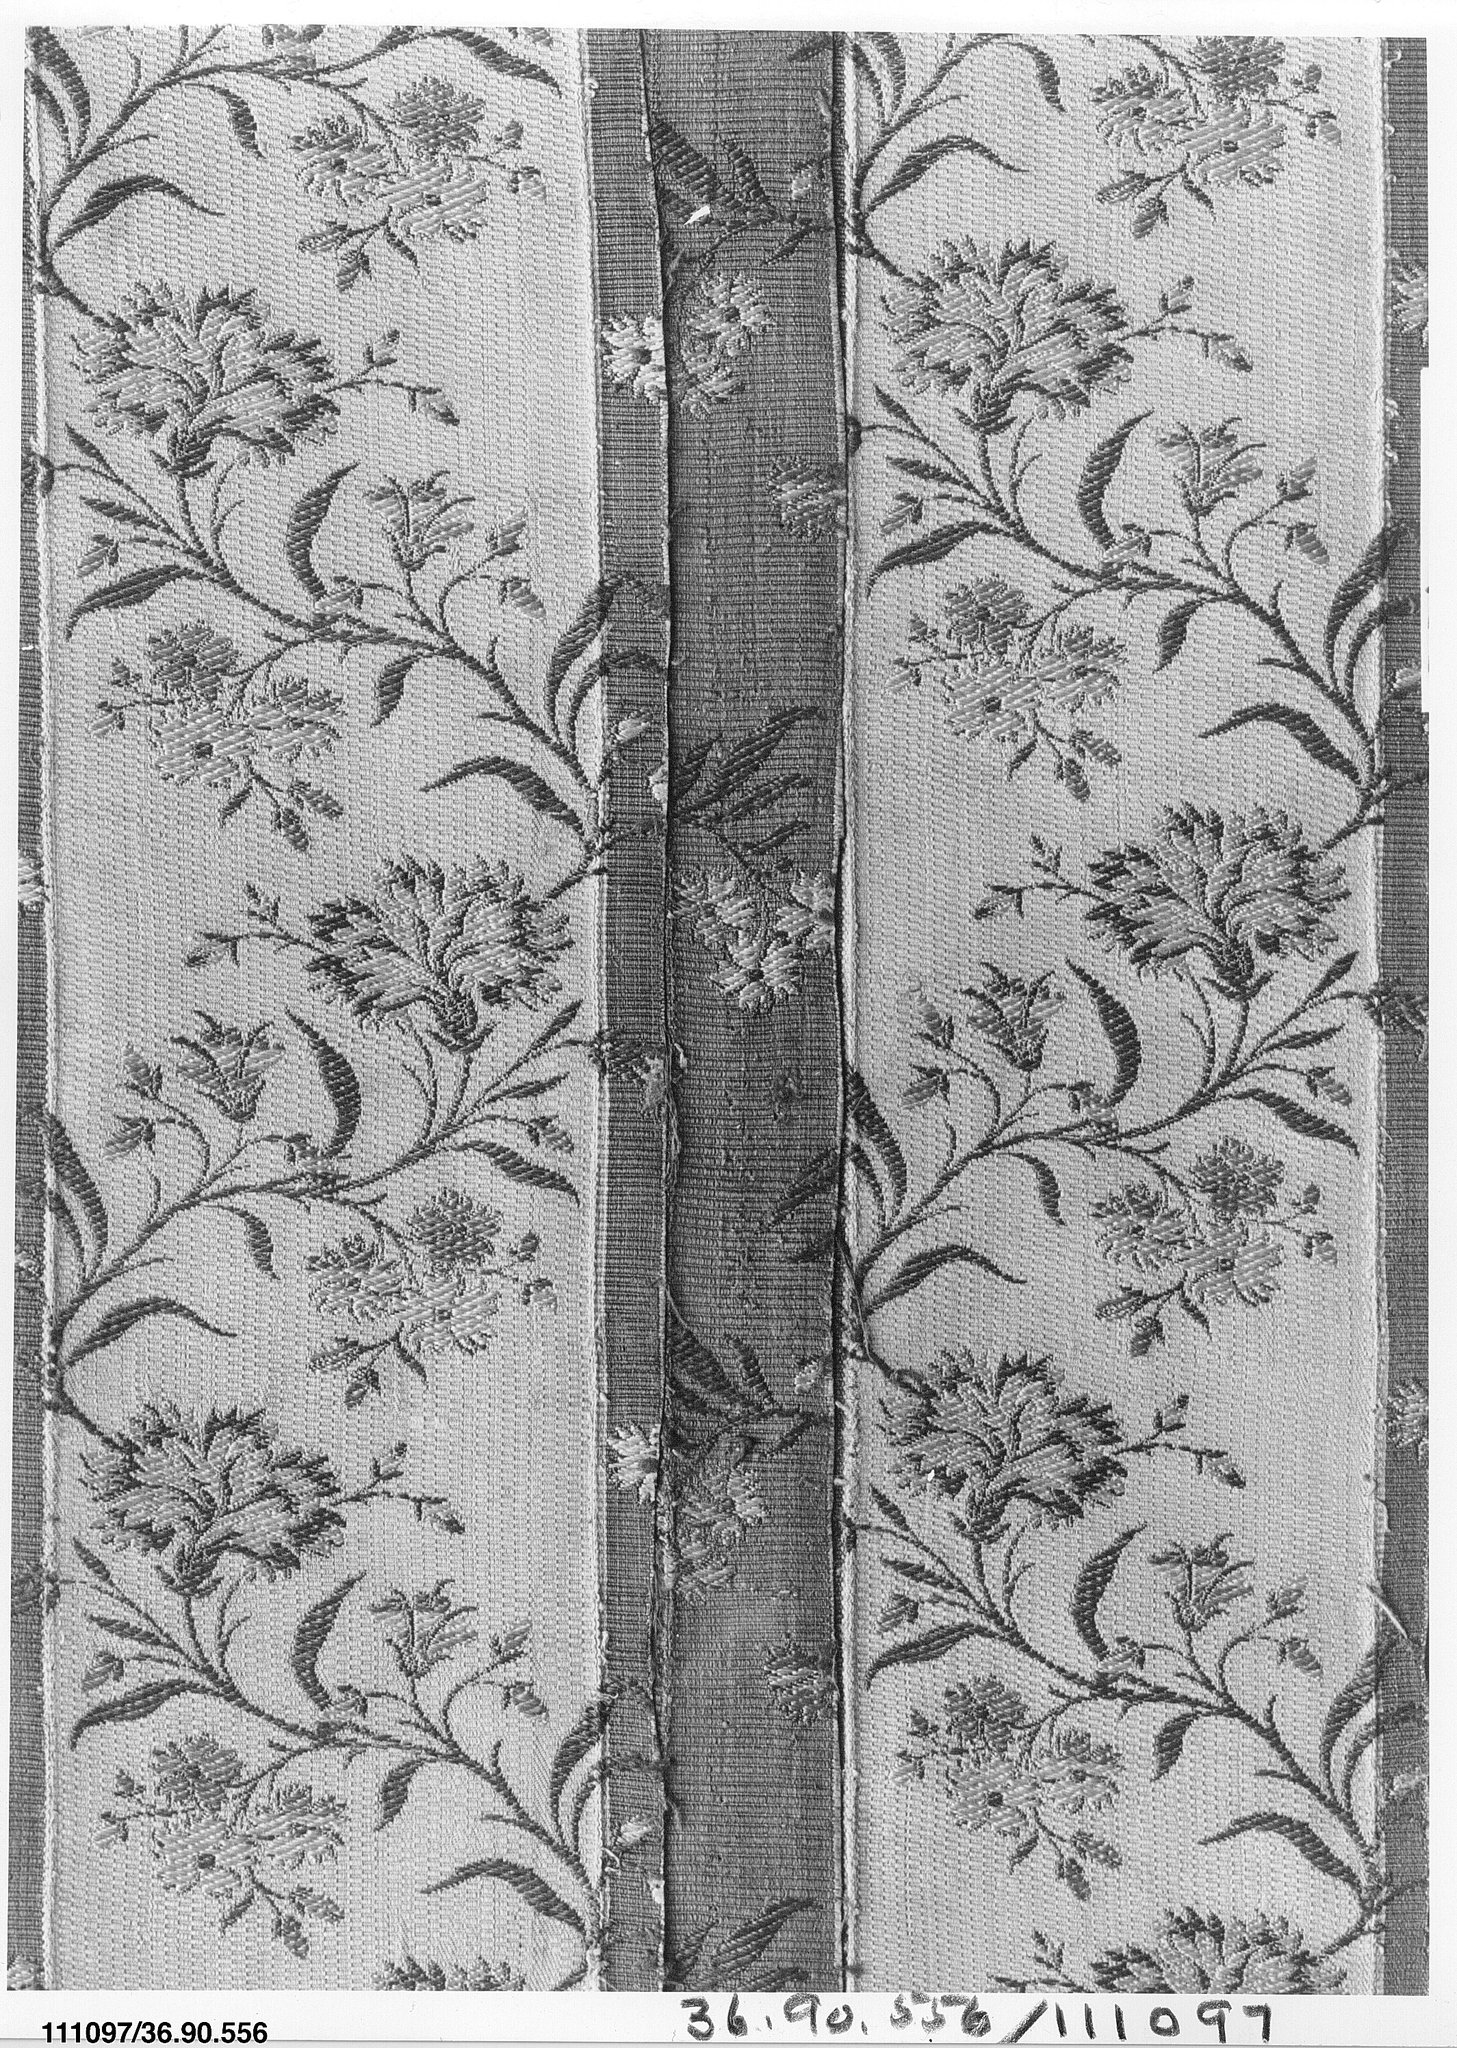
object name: piece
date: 1767-1800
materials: silk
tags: flowers,leaves